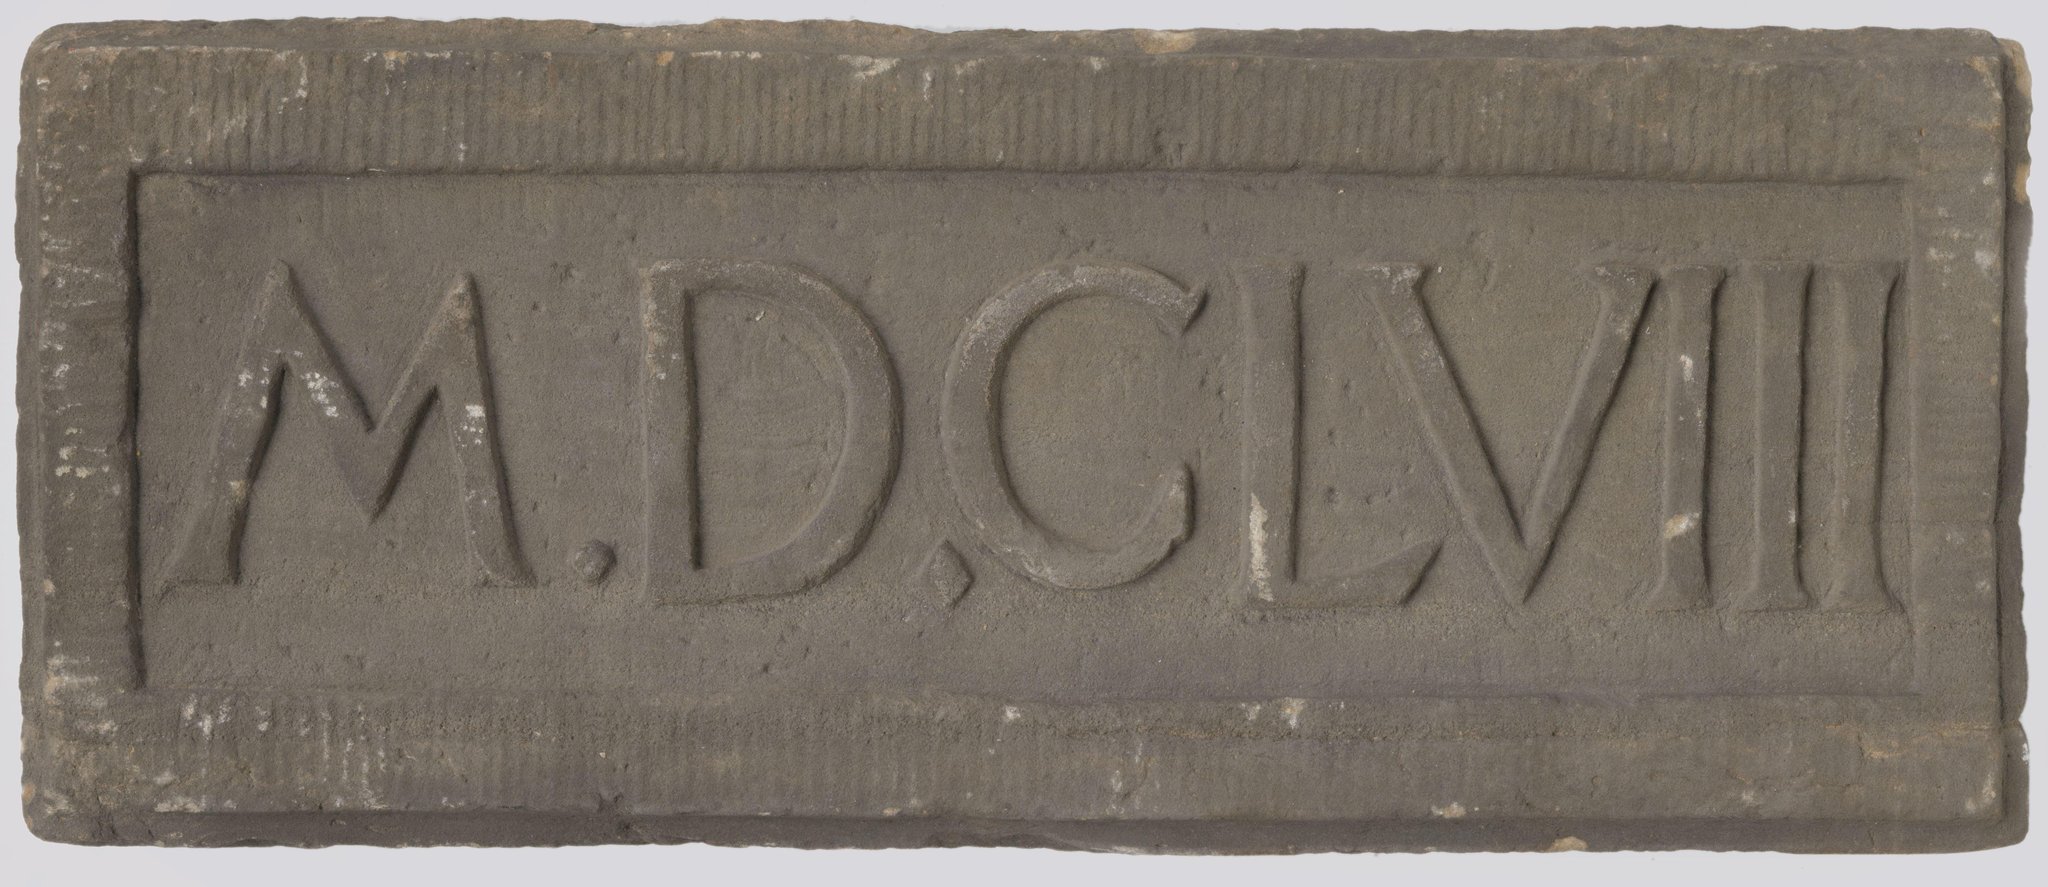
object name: gable stone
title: Gevelsteen met opschrift MDCLVIII.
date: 1658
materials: stone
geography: netherlands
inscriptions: date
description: Liggende rechthoek met een gearceerde rand en het opschrift MDCLVIII. De steen hoort bij een gevelsteen met invnr. KOG-ALS-69-1 (de Haringbuis).